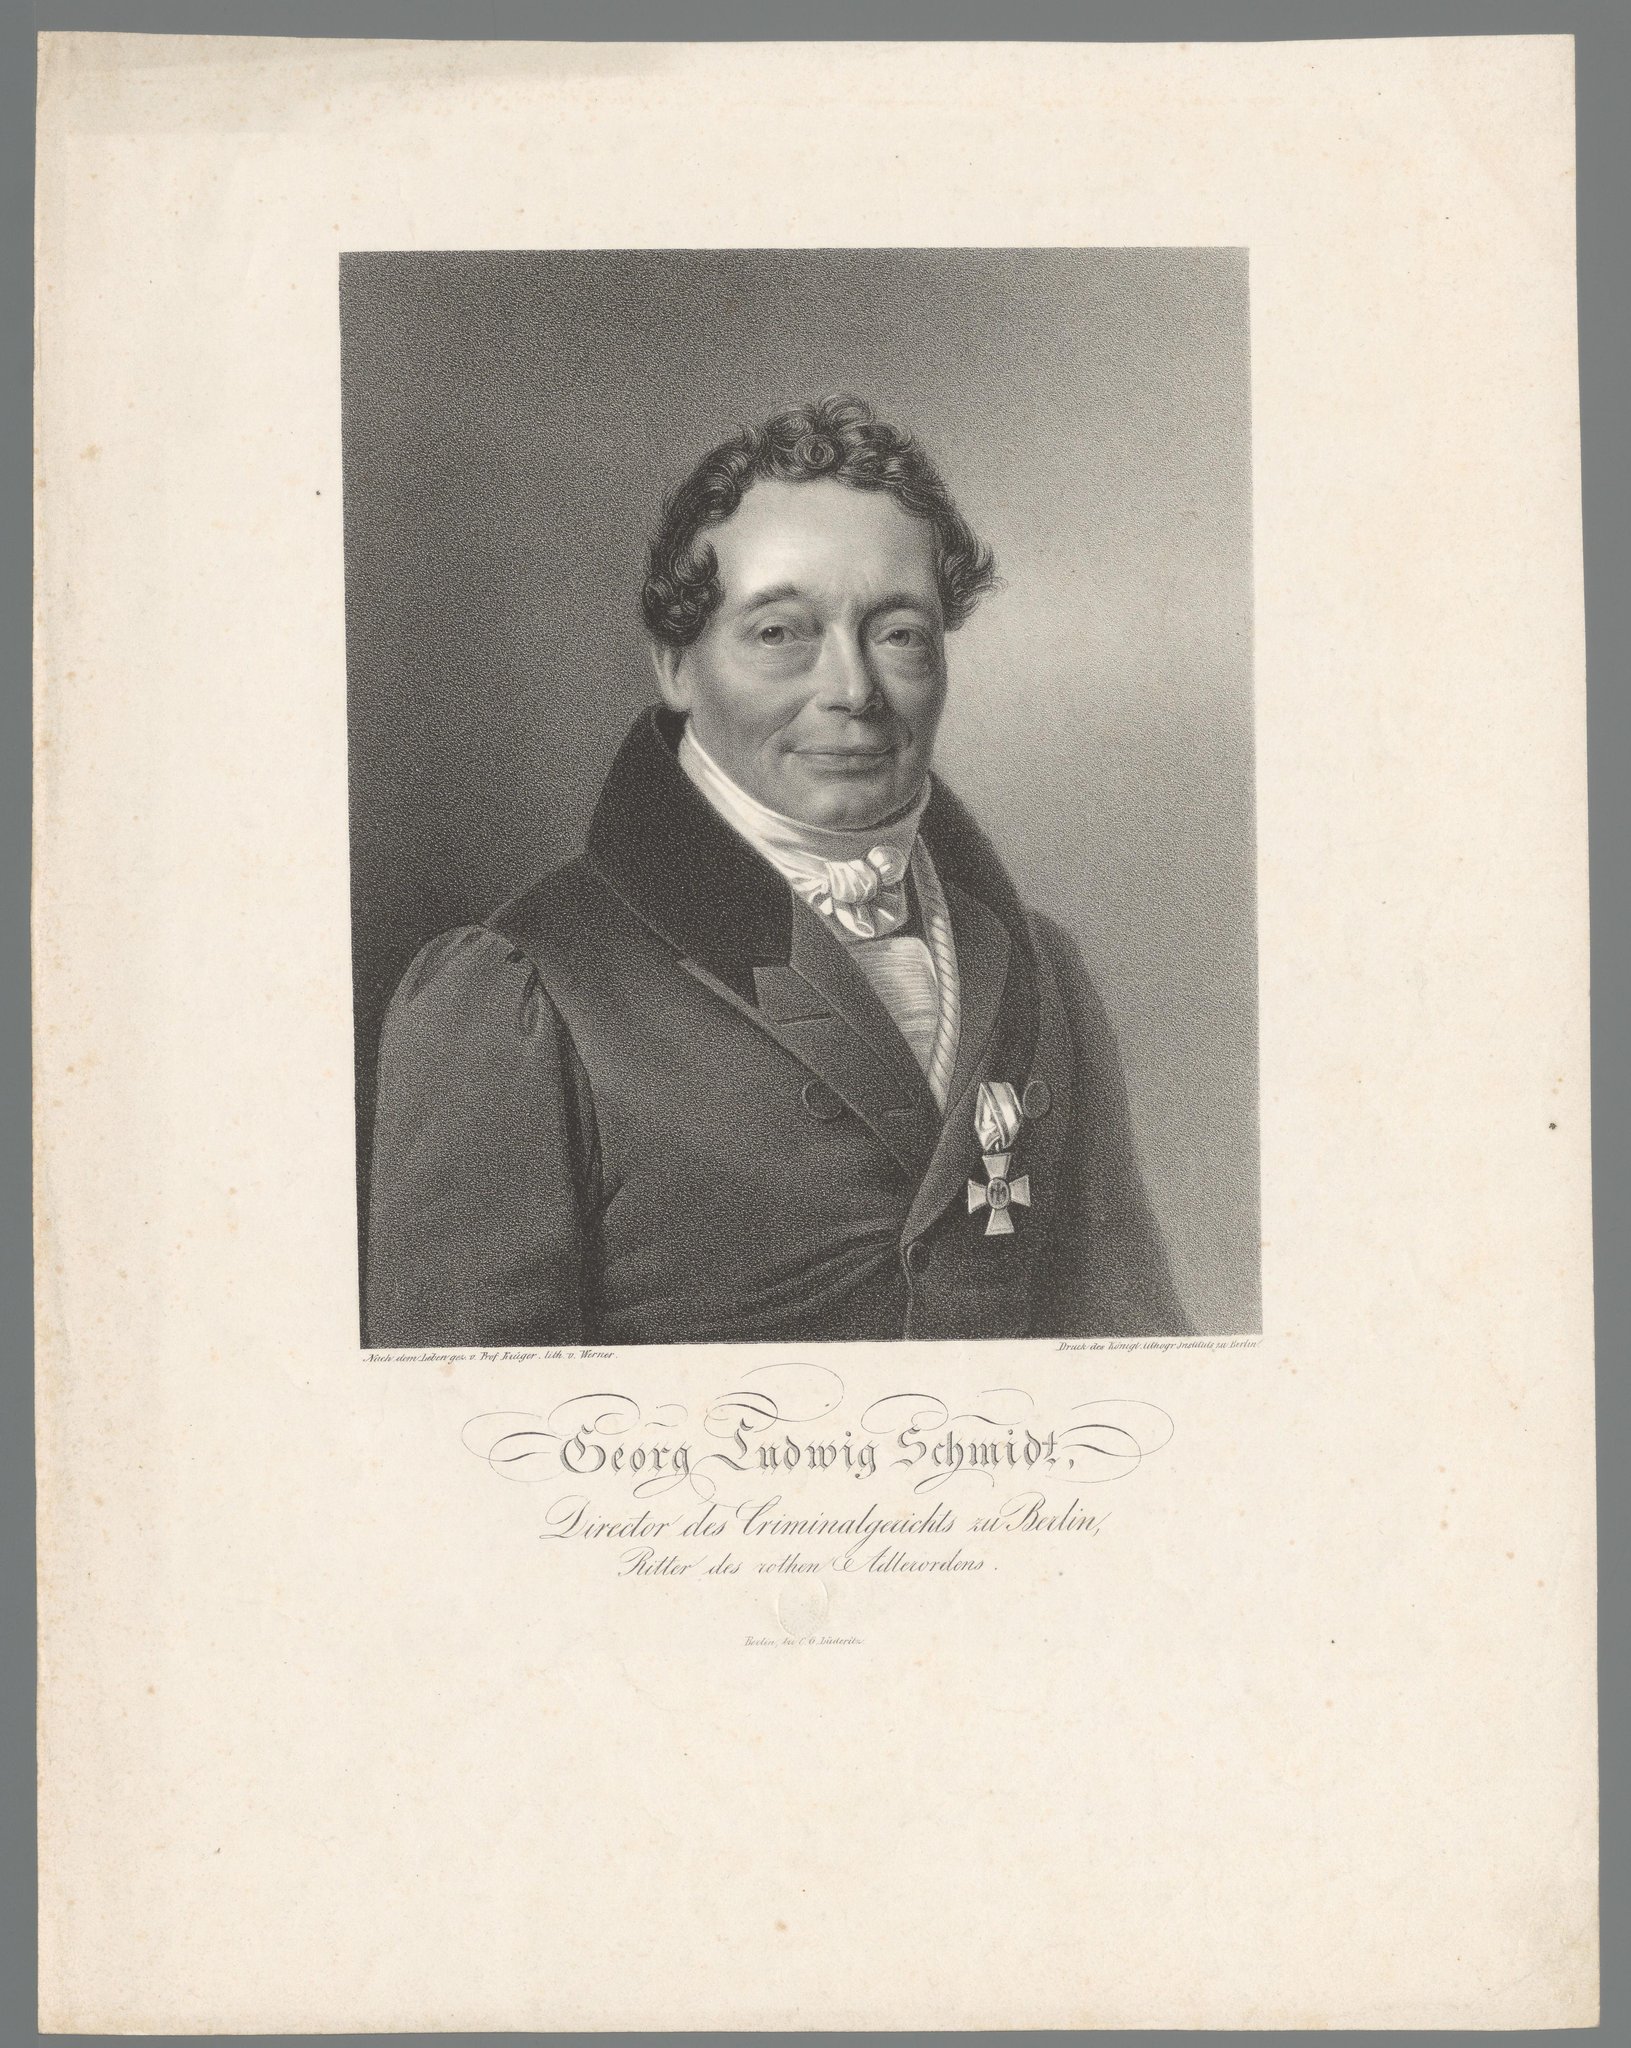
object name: print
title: Georg Ludwig Schmidt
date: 1830-1860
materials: paper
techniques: lithograph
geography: berlin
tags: historical persons not known by name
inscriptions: collector's mark: Lugt 2228, check stamp: Lugt 4519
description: Portret van een verder onbekende man met de naam Georg Ludwig Schmidt.